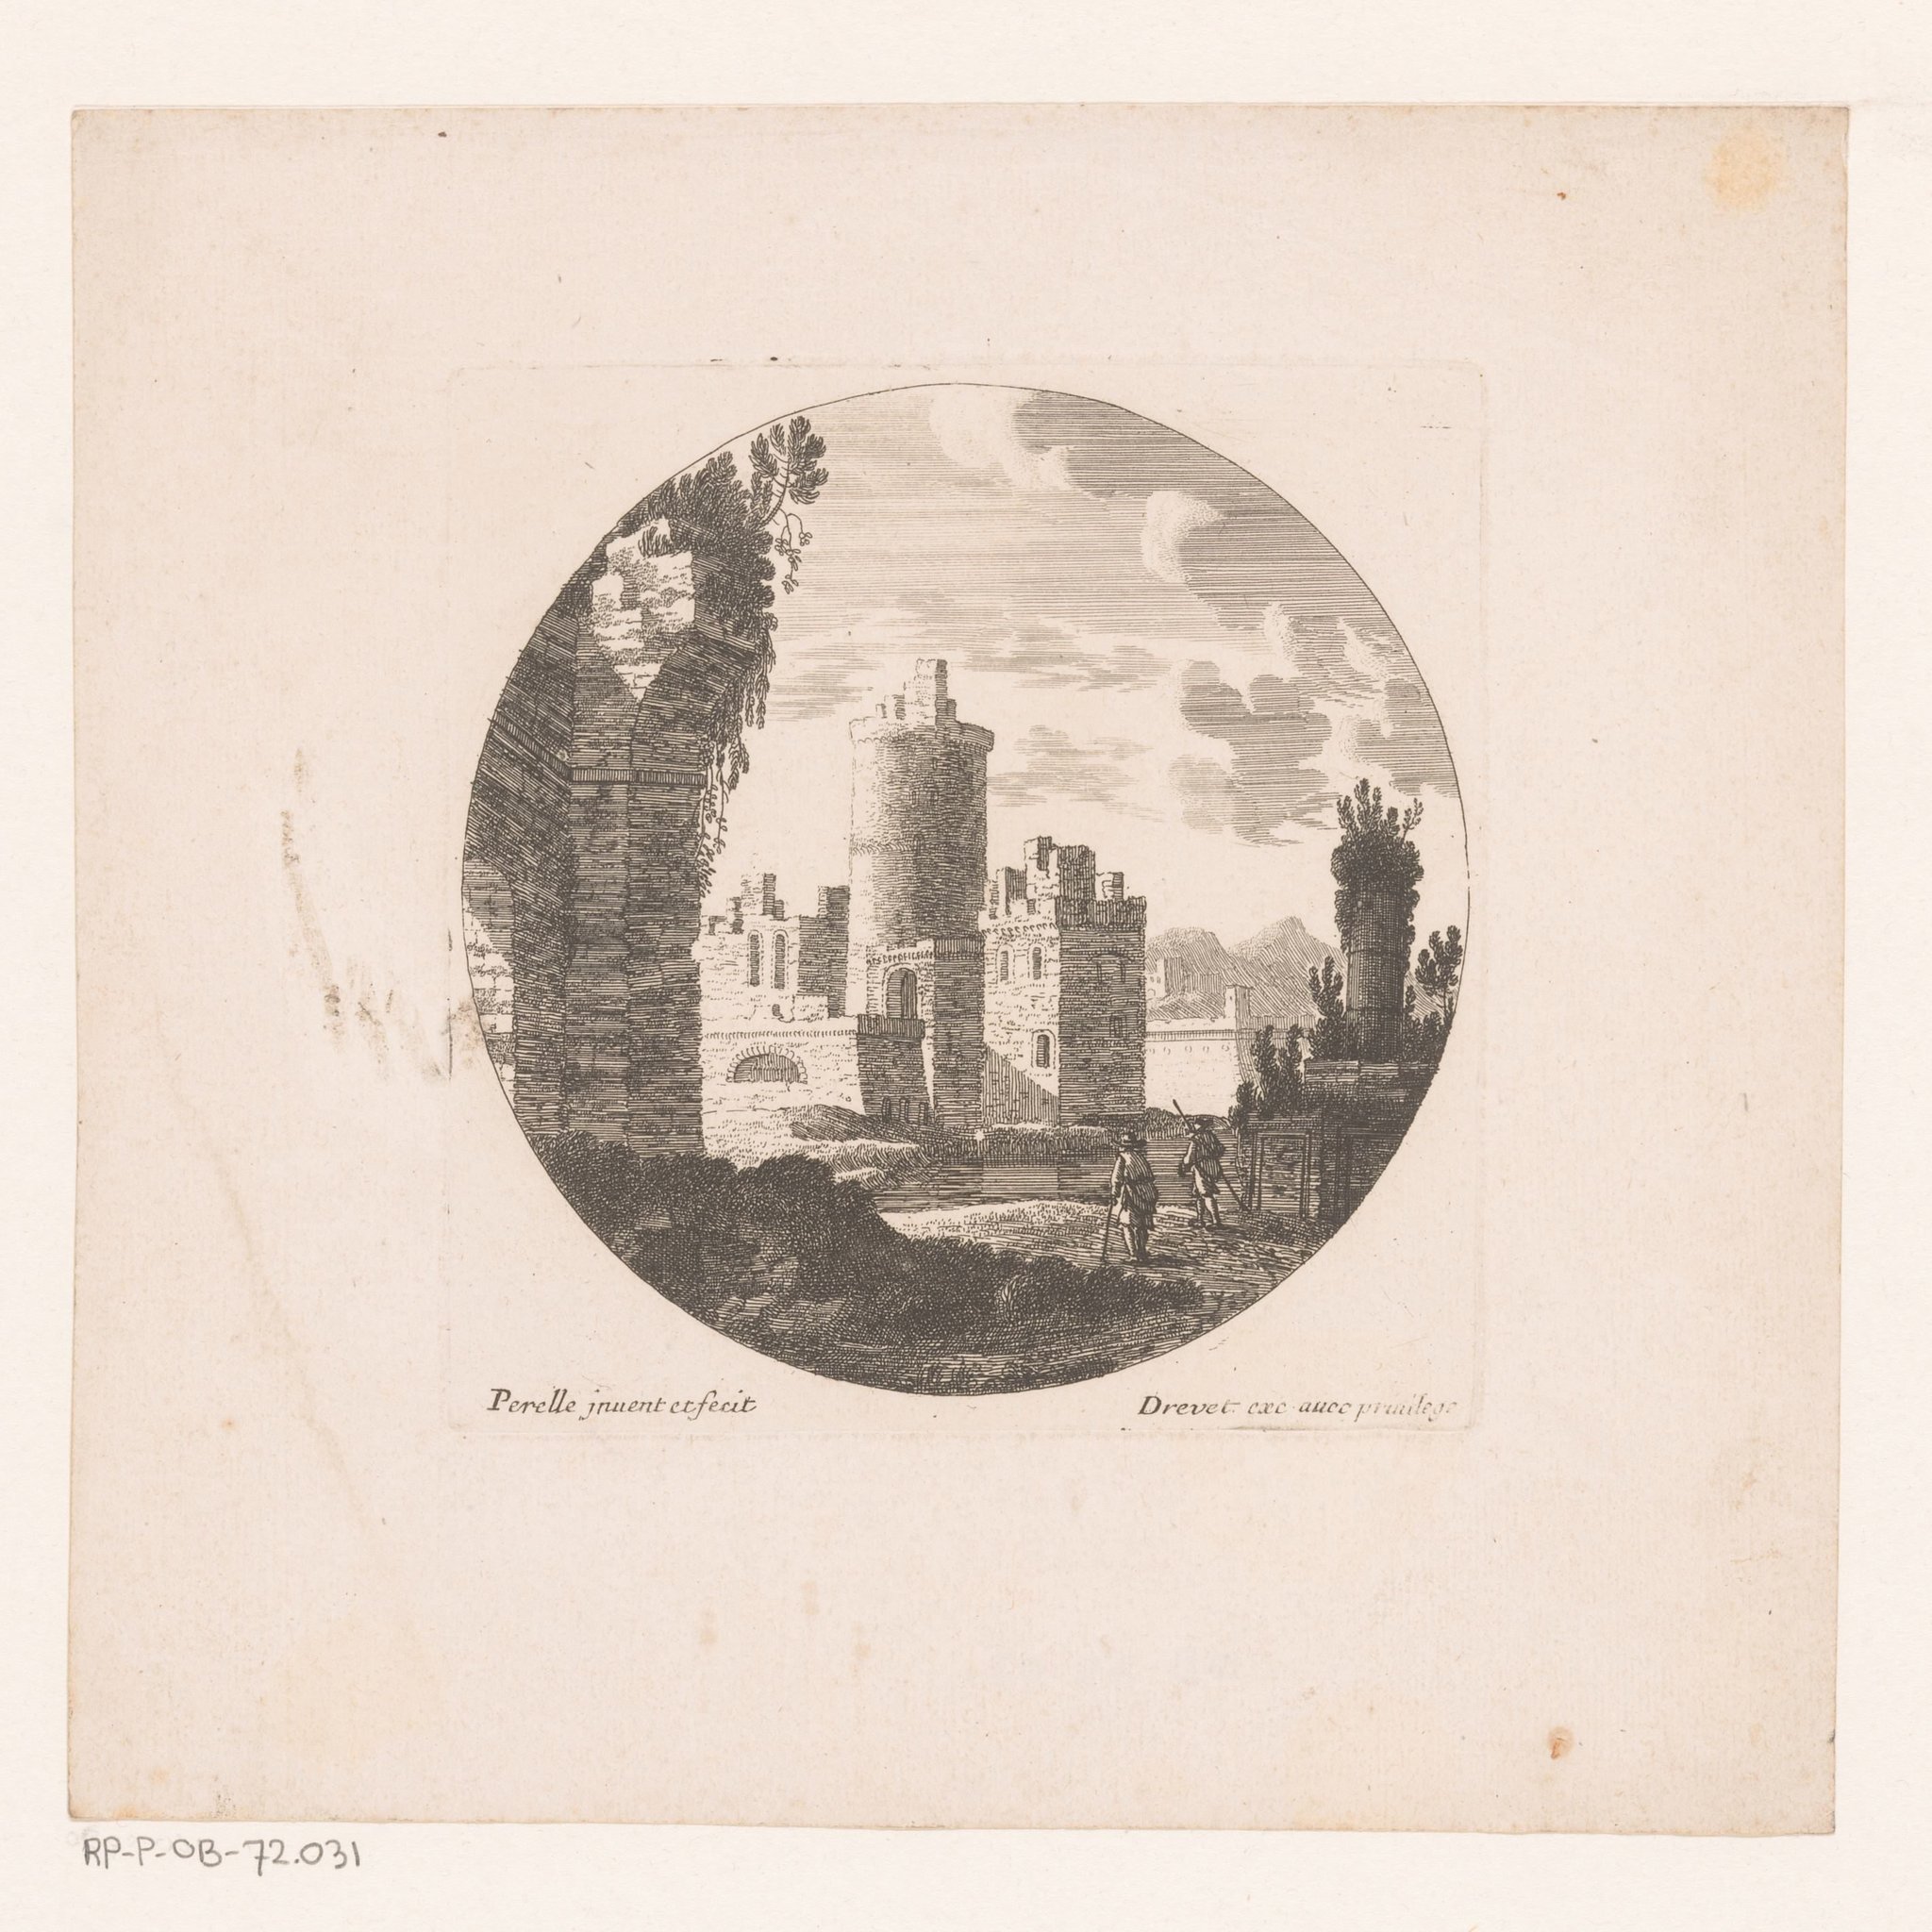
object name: print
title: Landschap met kasteel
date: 1673-1695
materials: paper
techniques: etching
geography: paris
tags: landscape with tower or castle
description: Prenten met het signatuur 'Perelle' kunnen zowel door vader Gabriel als door zonen Nicolas en Adam gemaakt zijn.